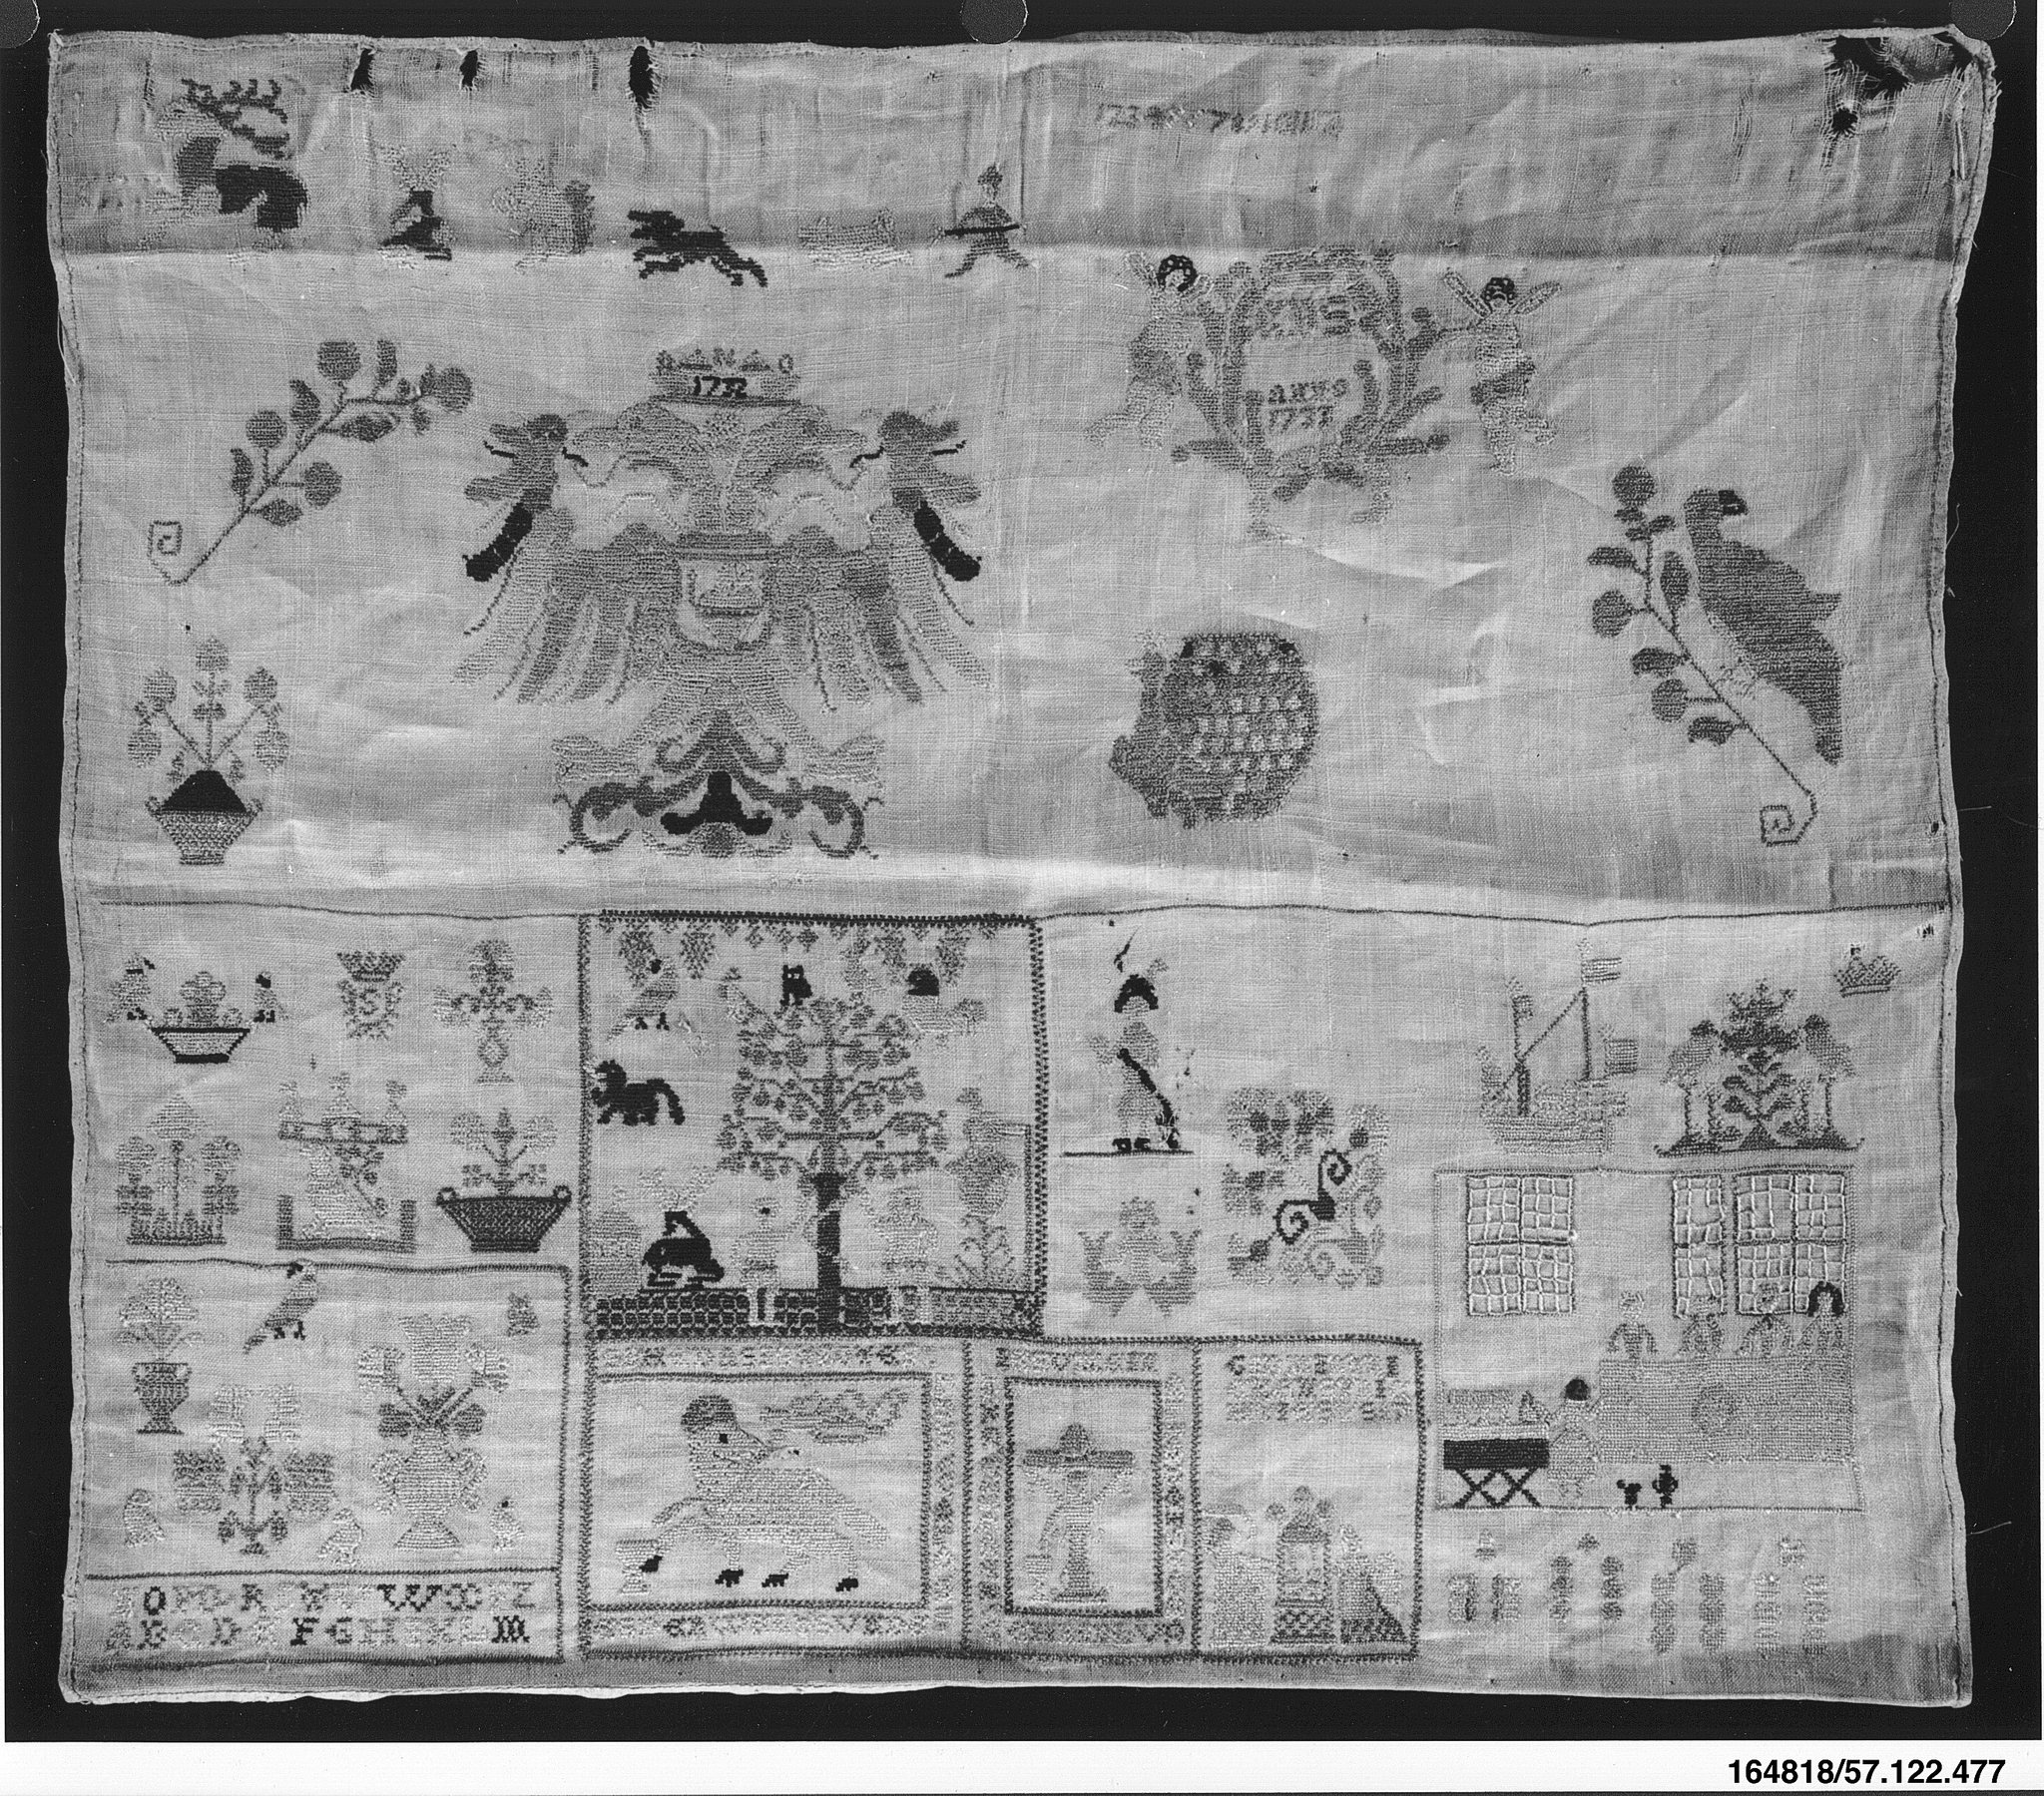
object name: sampler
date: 1722-1733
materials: linen, silk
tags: animals,birds,boats